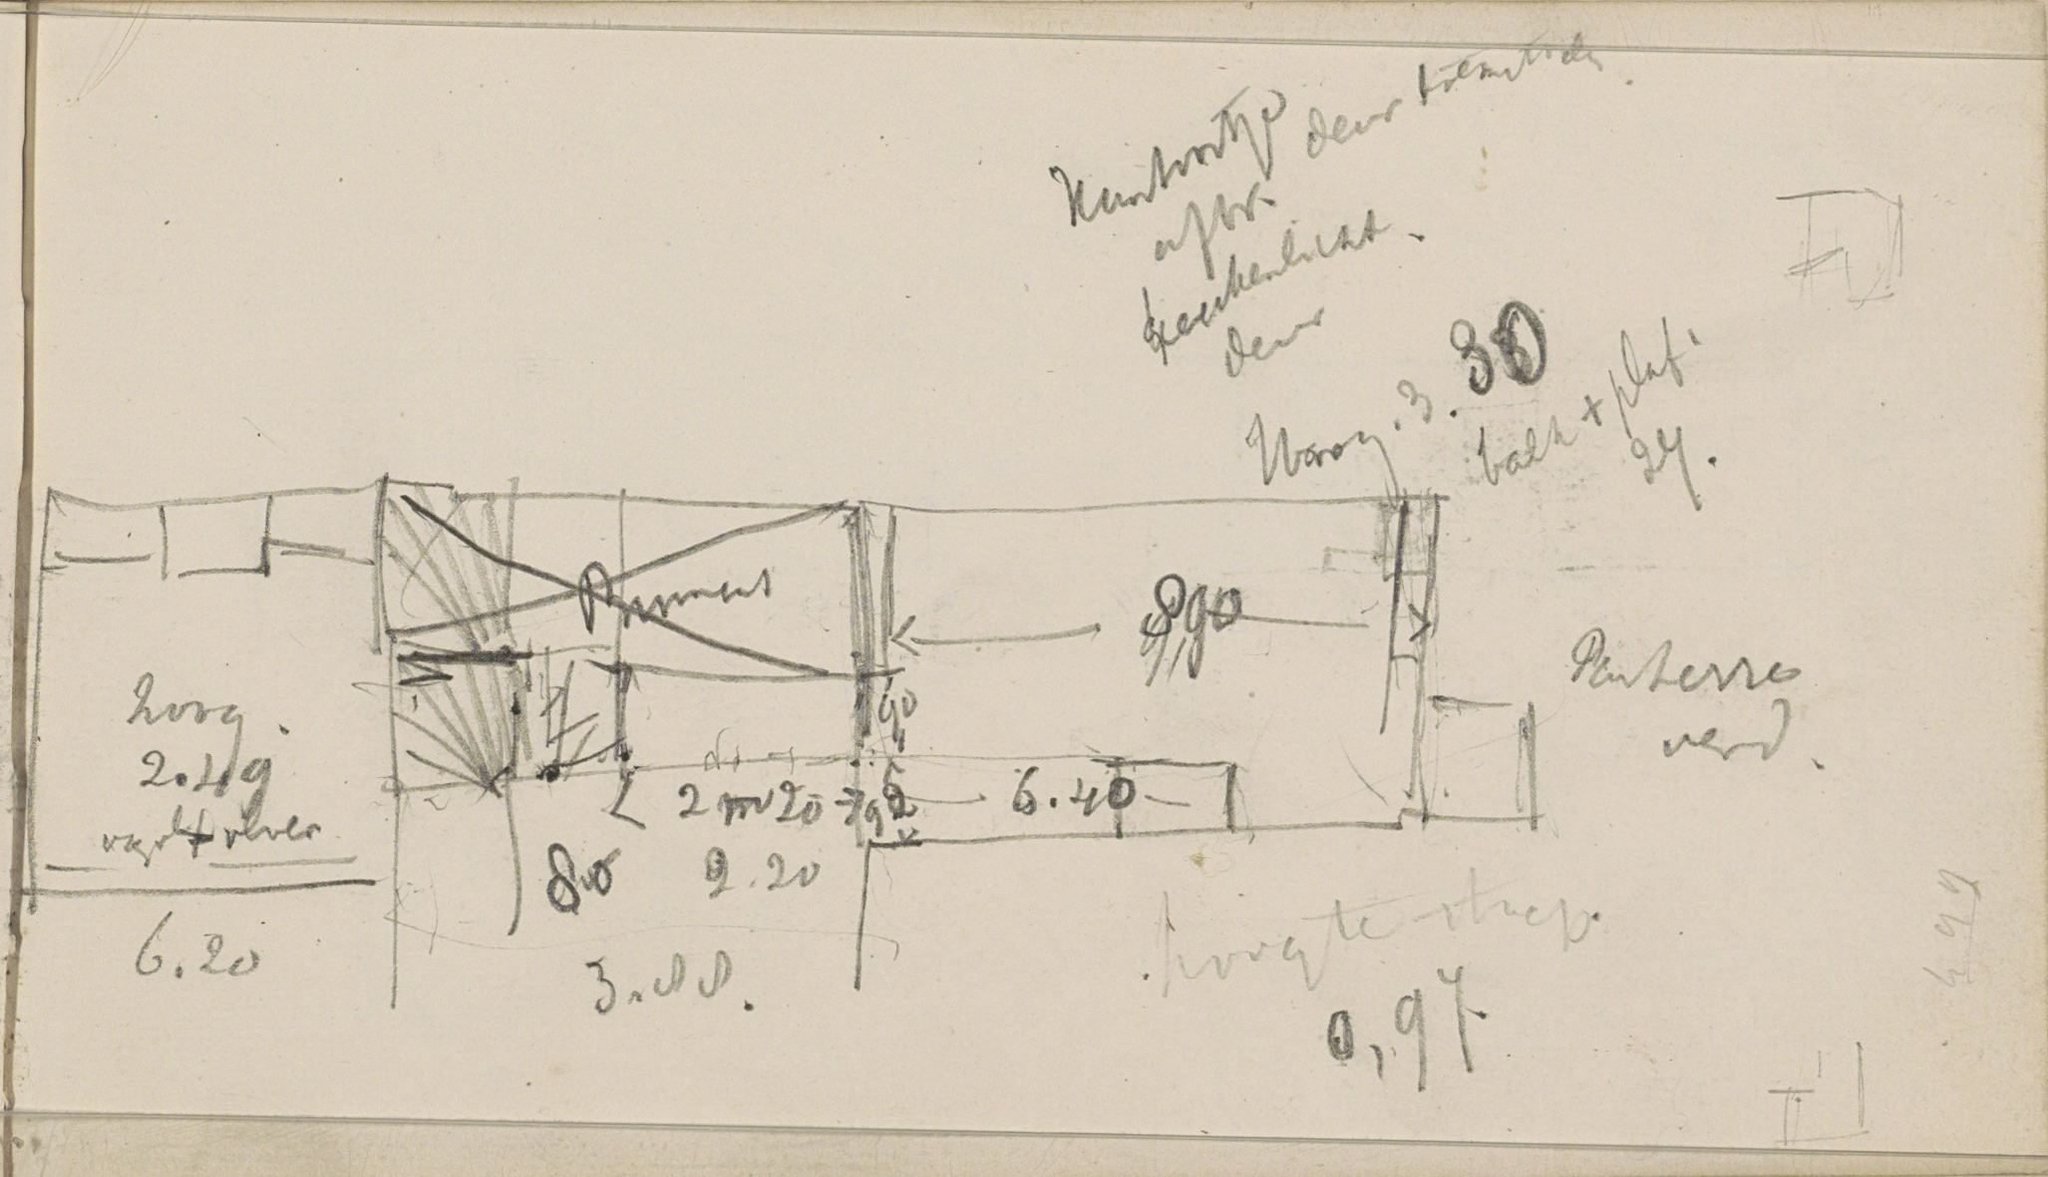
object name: sketchbook leaf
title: Plattegrond van een woning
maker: isaac gosschalk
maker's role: draughtsman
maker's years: 1838-1907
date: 1866-1868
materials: paper, pencil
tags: plan ~ architecture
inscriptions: annotation: ‘[...]’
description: Blad 22 recto uit een schetsboek met 67 bladen.